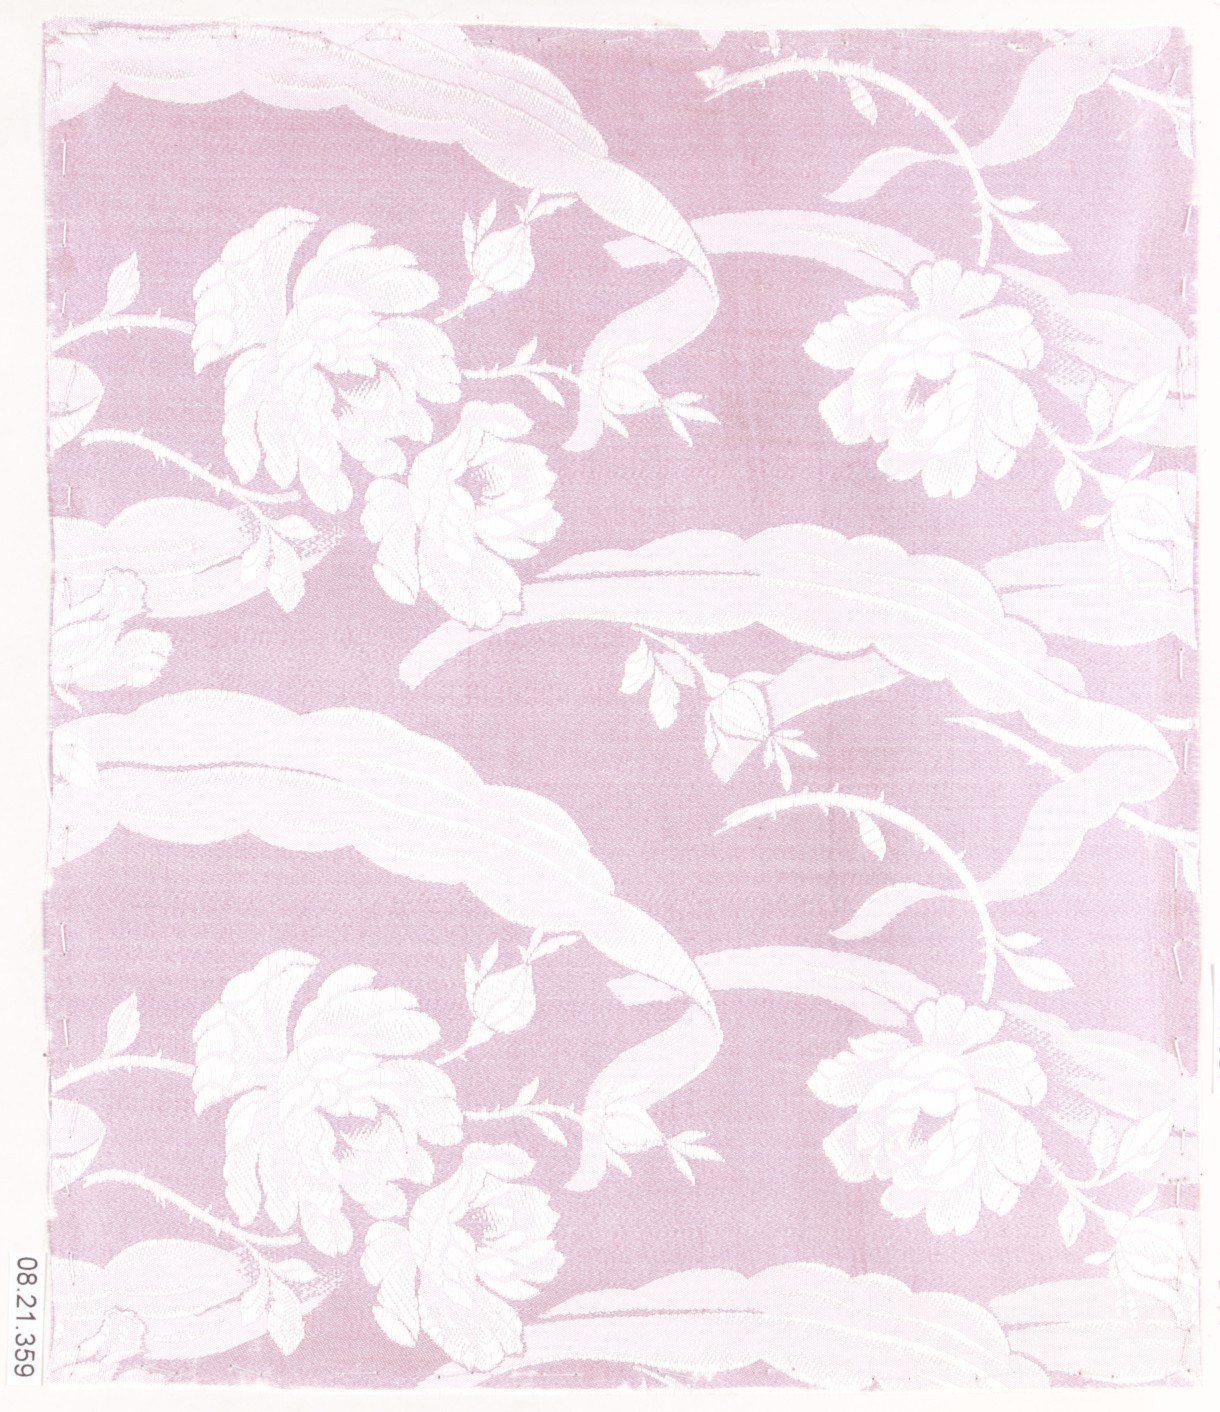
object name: textile sample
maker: Anonymous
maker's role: designer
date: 1900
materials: silk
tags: flowers